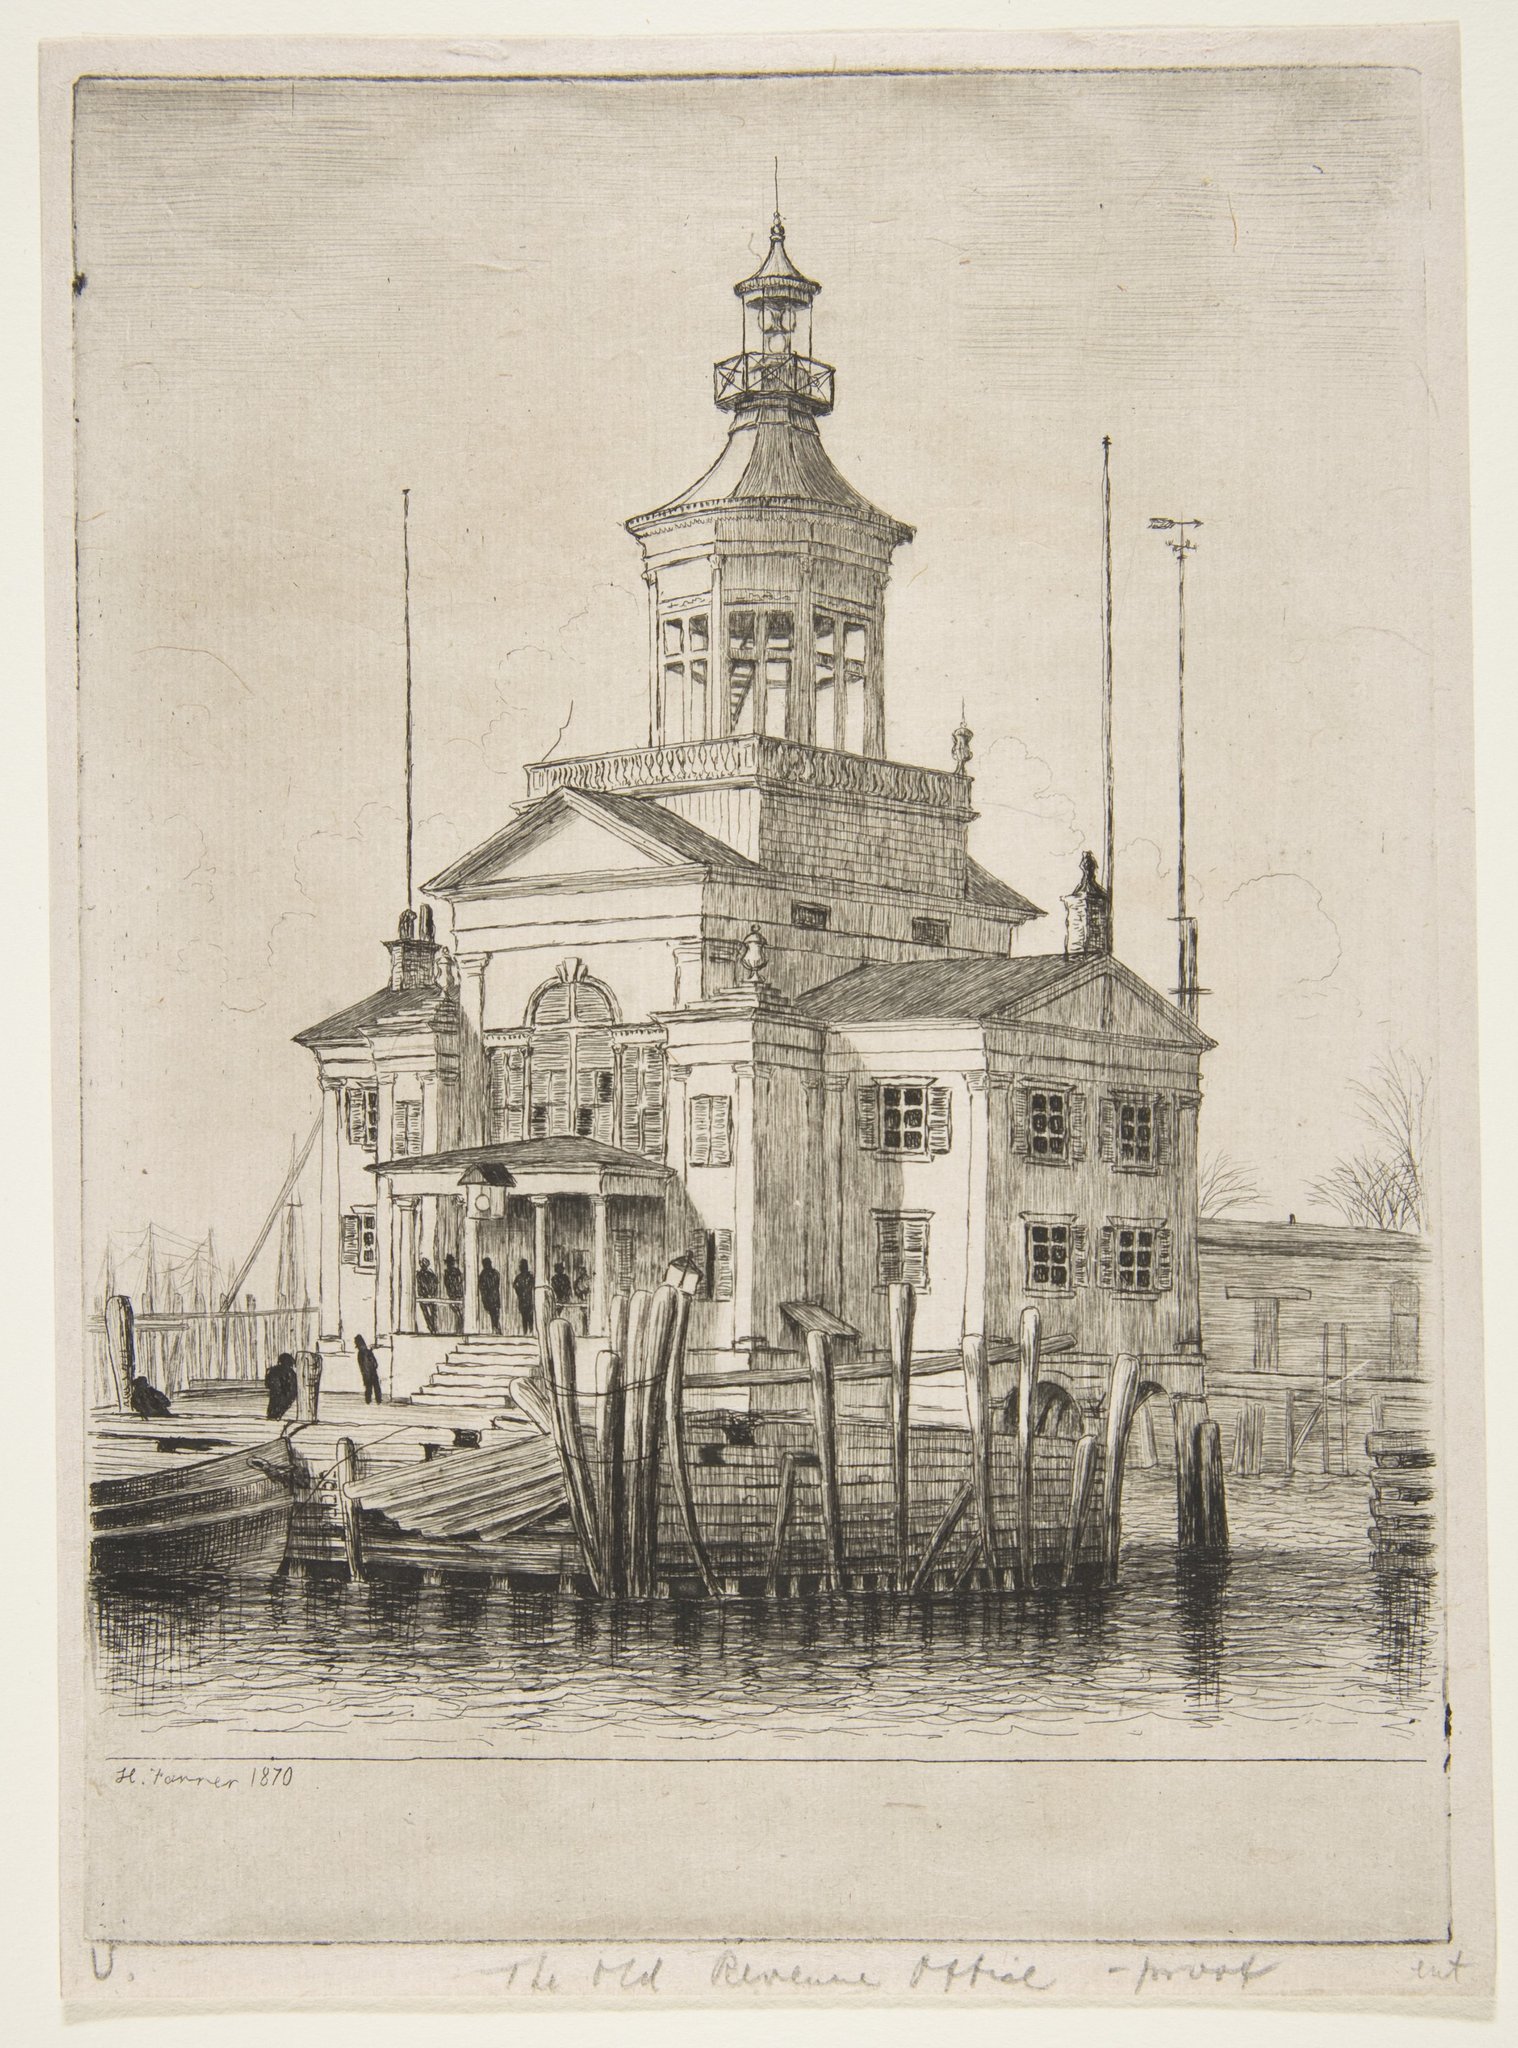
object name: print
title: The Old Revenue Office, Whitehall, from "Scenes of Old New York"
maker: henry farrer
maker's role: artist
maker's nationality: american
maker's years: 1844-1903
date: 1870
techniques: etching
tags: buildings,new york city